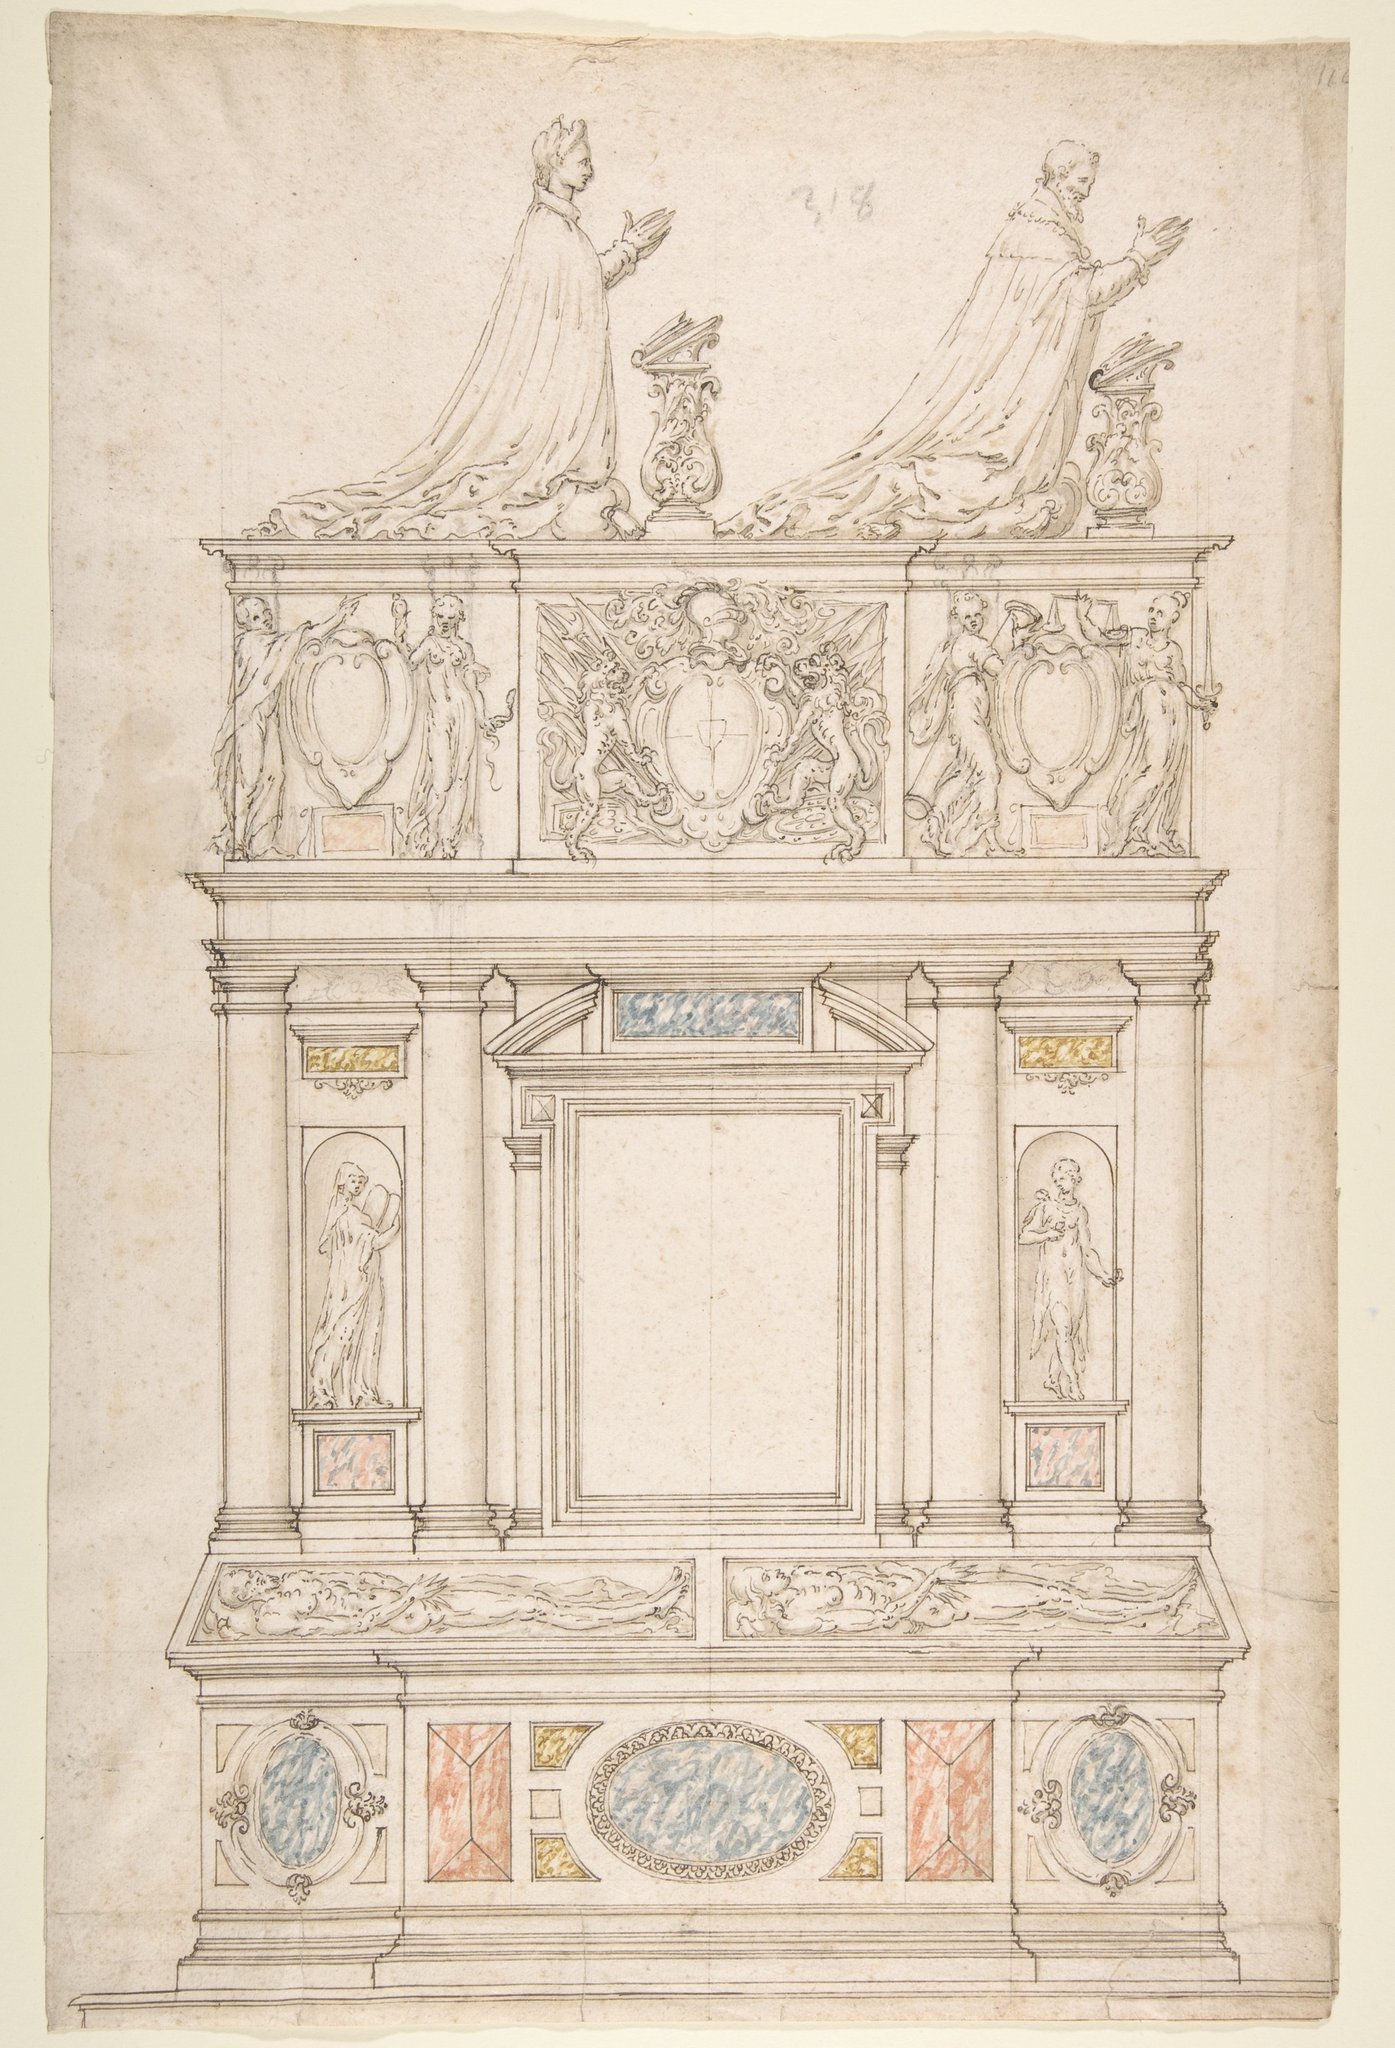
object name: drawing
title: Design for a Double Tomb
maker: anonymous, french, 16th century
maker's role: artist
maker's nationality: french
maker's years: 1500-1600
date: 1501-1600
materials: chalk, ink, watercolor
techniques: pen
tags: tombs,men,women